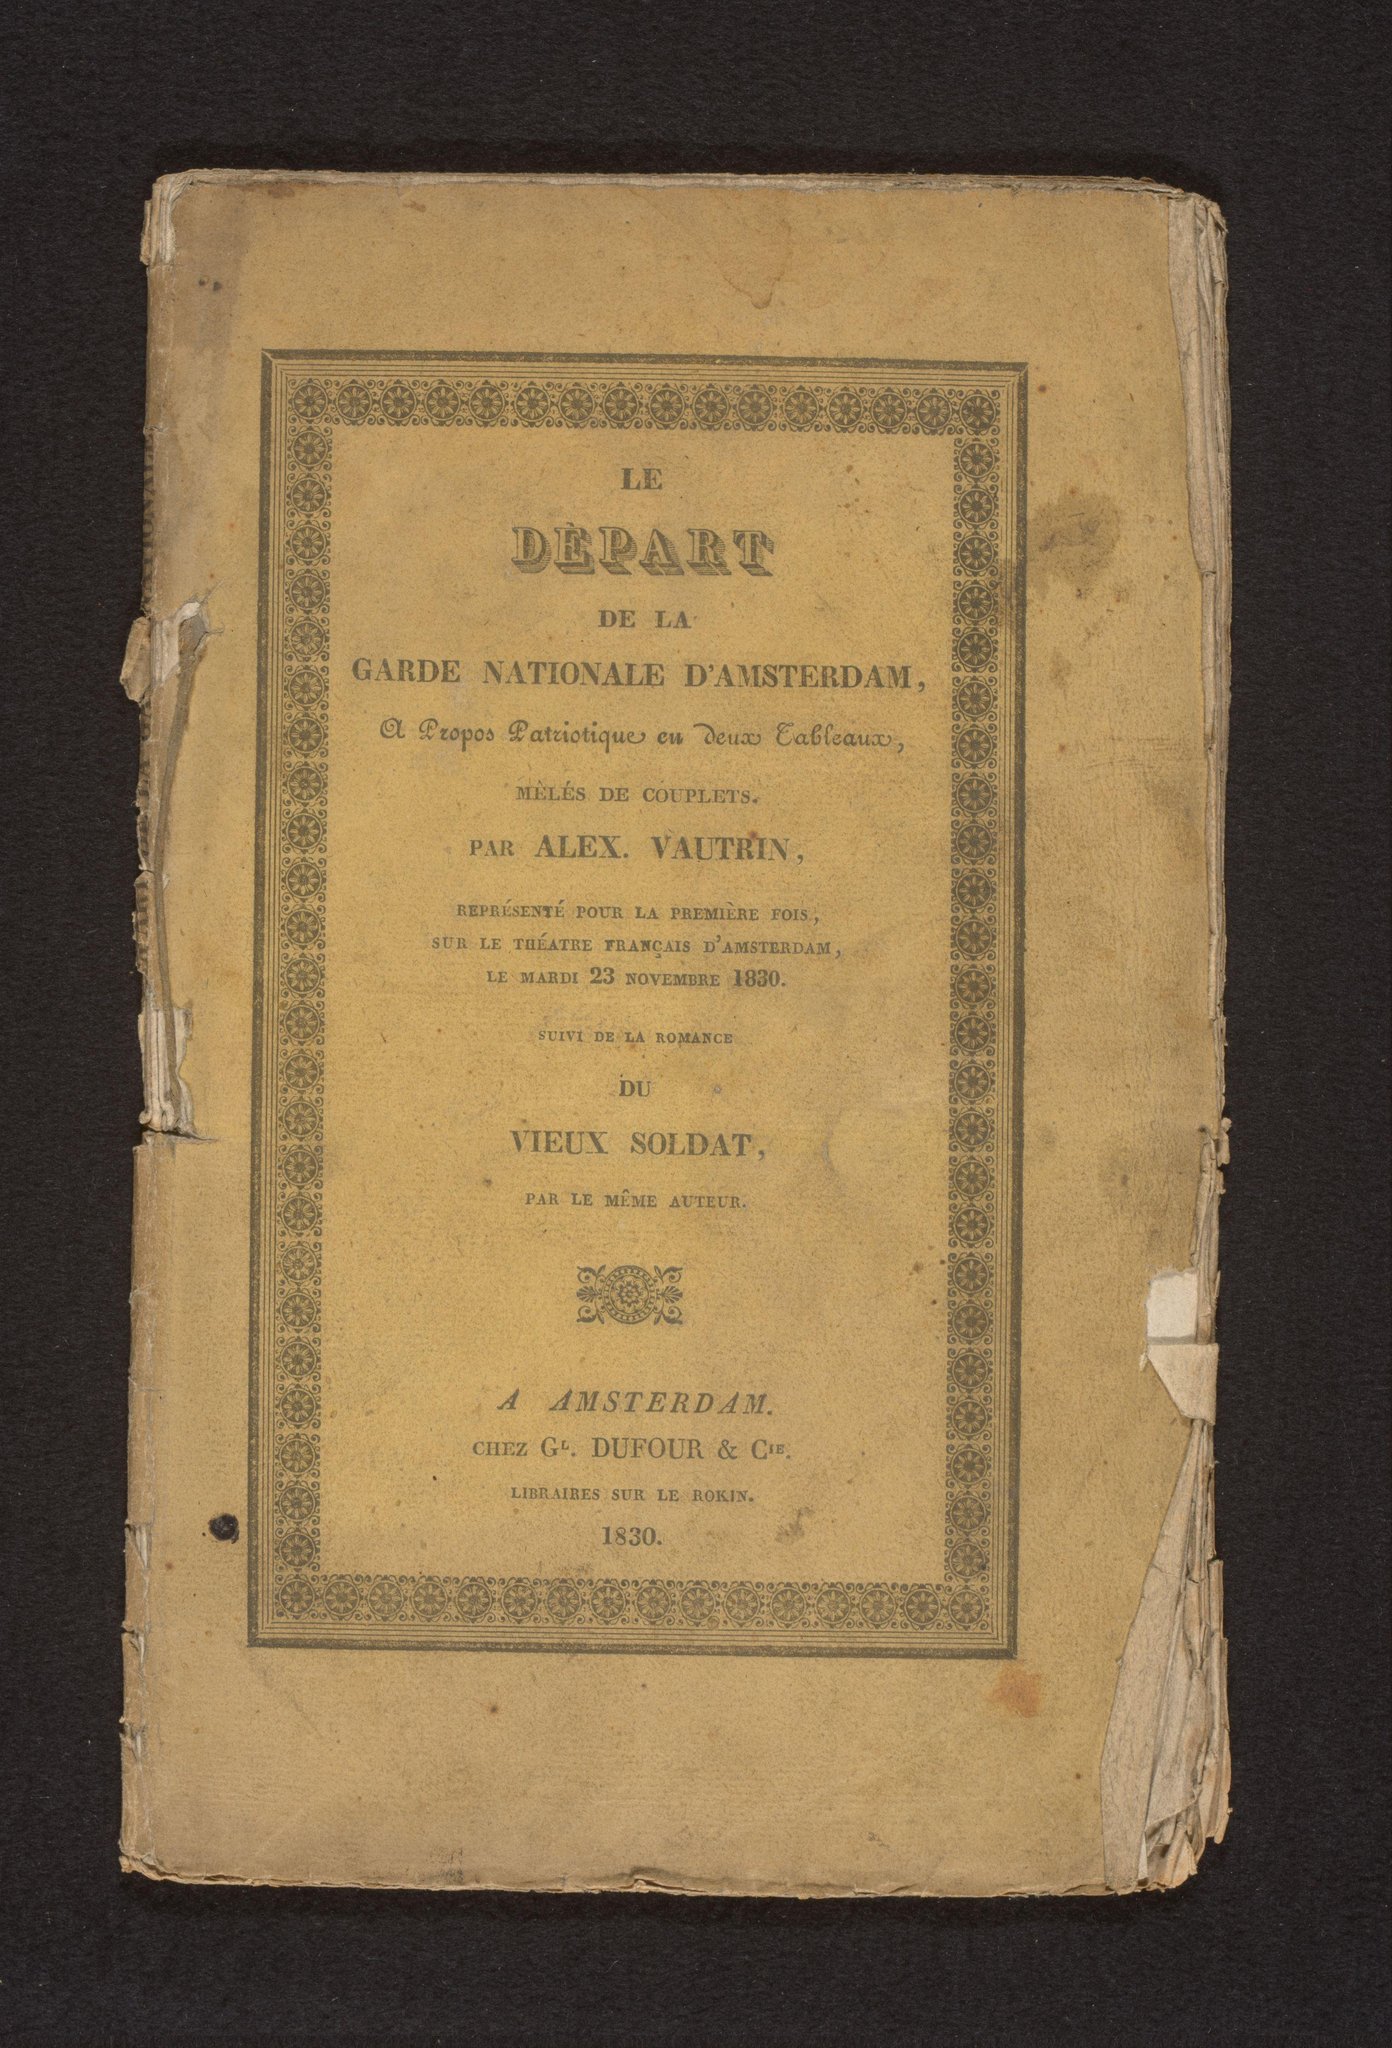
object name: brochure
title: Le Depart de la Garde Nationale d'Amsterdam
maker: alex. vautrin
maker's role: schrijver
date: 1830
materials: paper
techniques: printing, sewing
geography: amsterdam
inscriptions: date